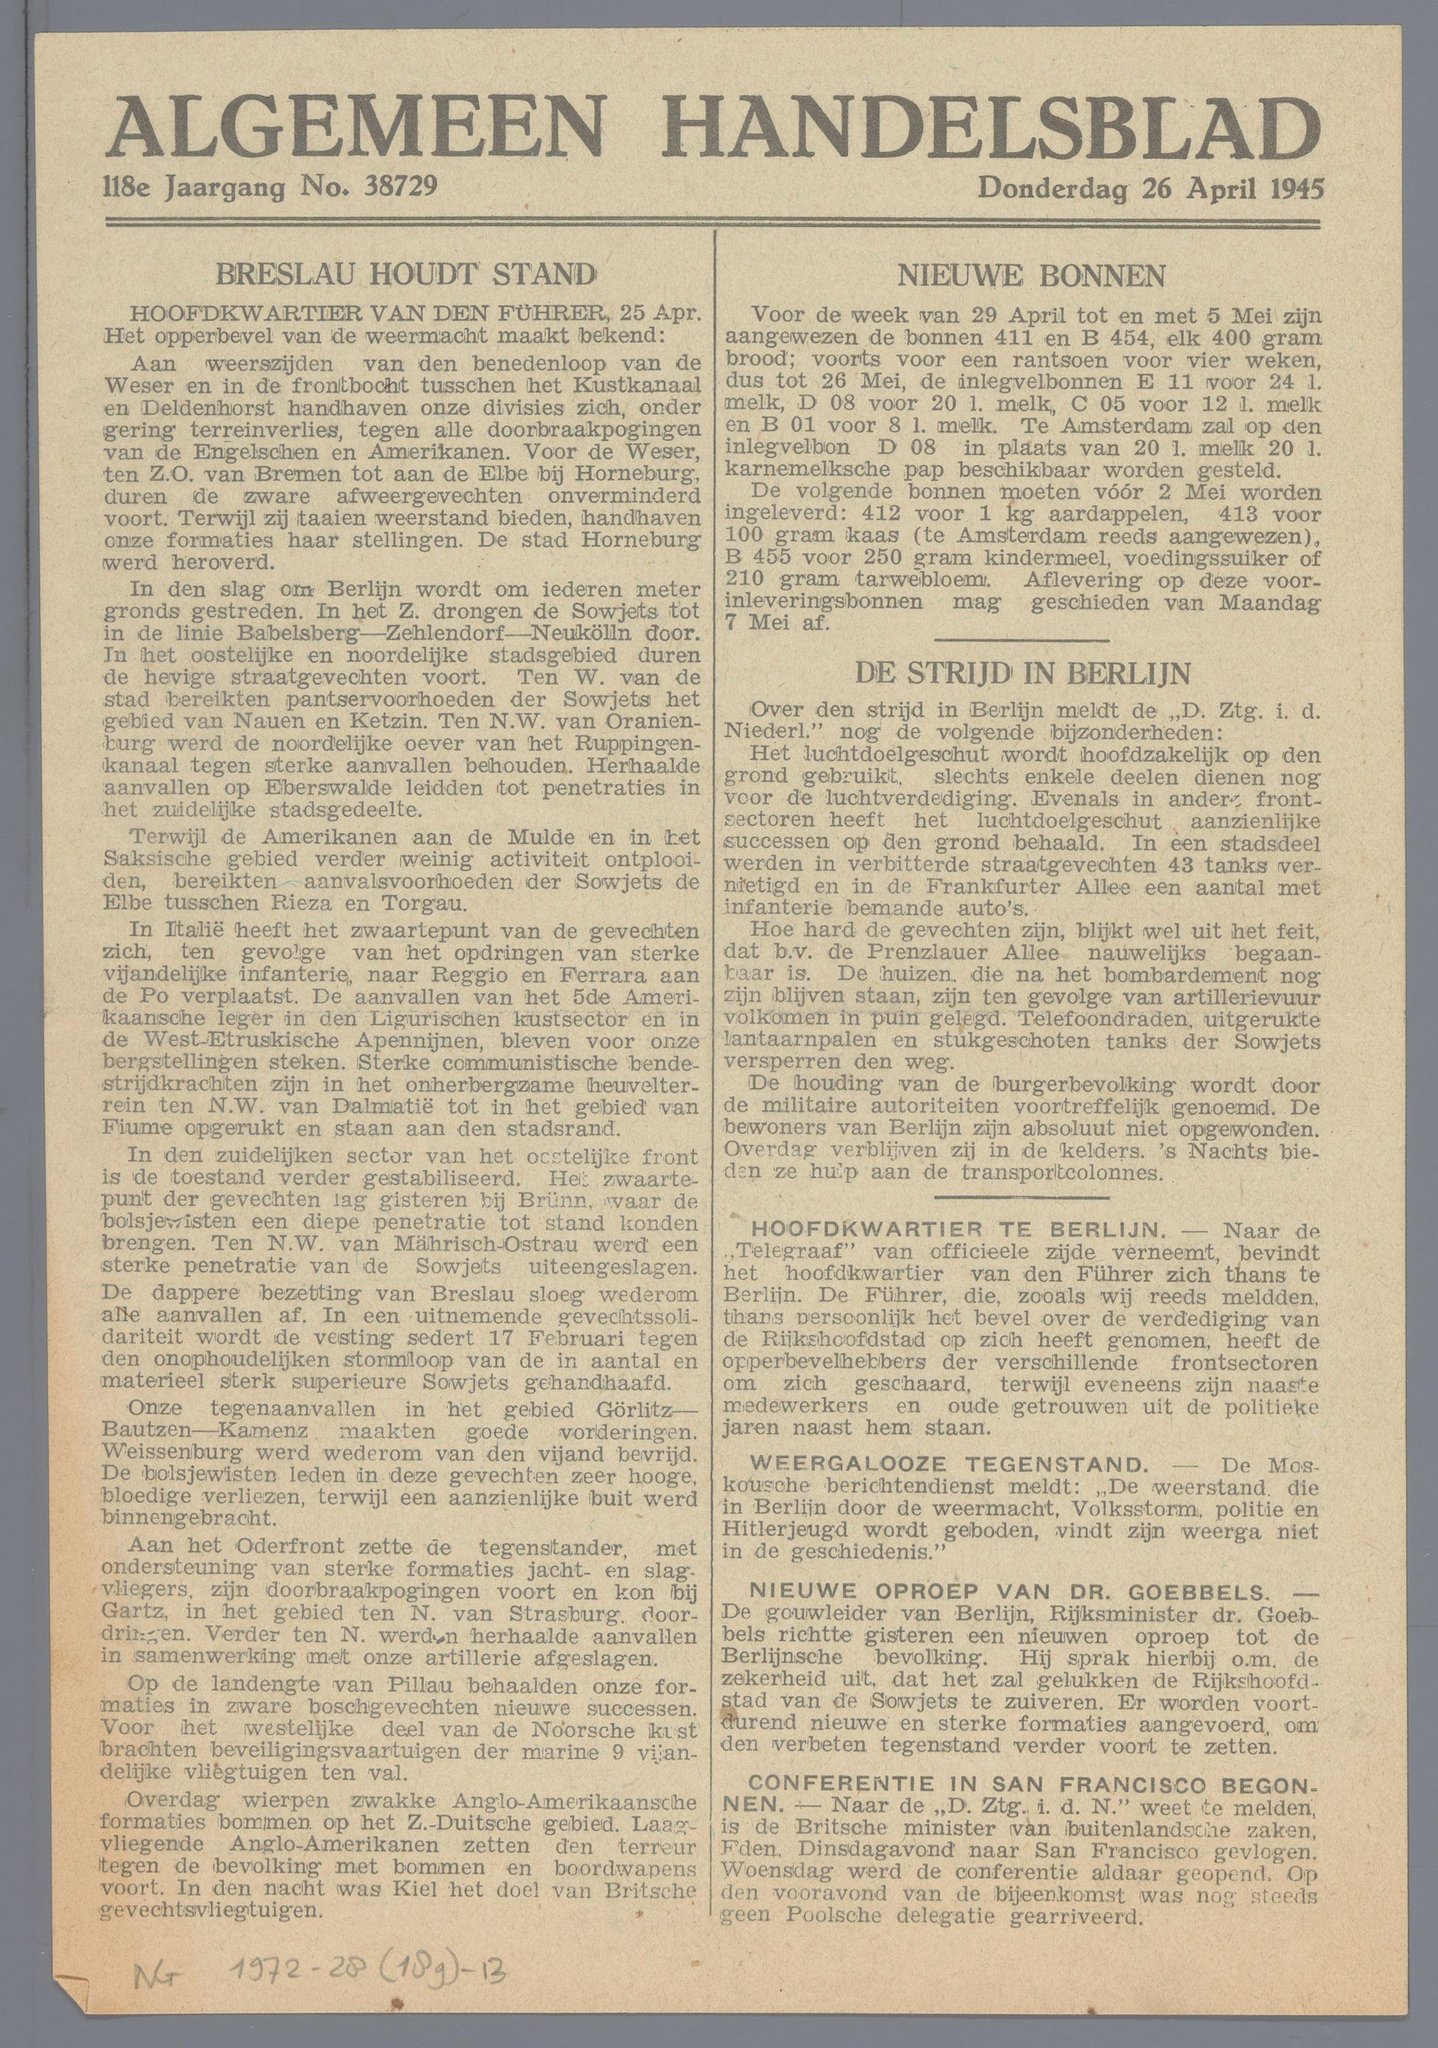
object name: newspaper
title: Algemeen Handelsblad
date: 1945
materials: paper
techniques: printing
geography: amsterdam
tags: tweede wereldoorlog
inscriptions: date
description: Krant, klein formaat, met bericht over de oorlog uit Duits gezinde hoek. Gedateerd: Donderdag, 26-04-1945.